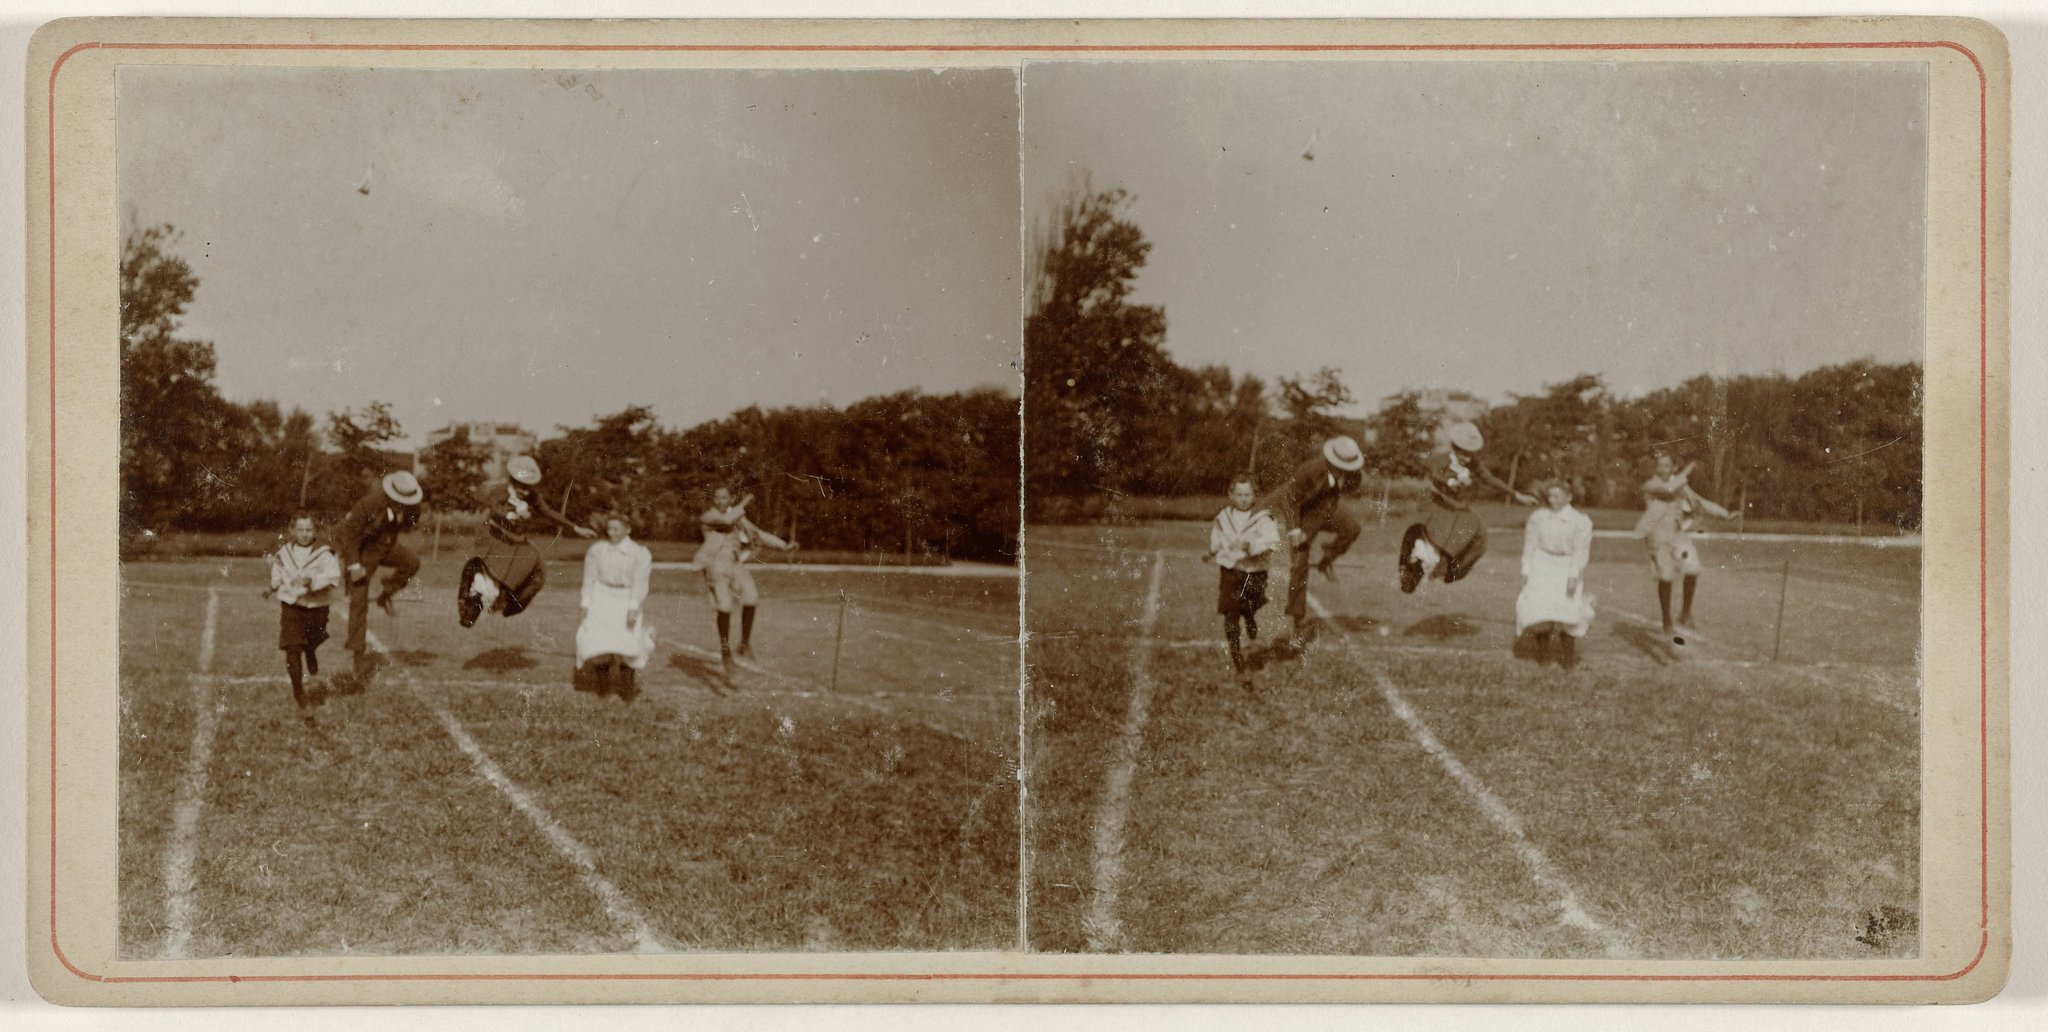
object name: stereograph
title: Stereoscopic Photographs of the Photographer’s Children Running and Jumping, Domburg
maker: geldolph adriaan kessler (dolph)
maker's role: fotograaf, industrieel, voetballer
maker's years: 1884-1945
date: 1899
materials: cardboard, paper, photographic support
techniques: collodion silver print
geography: domburg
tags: domburg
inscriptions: title: ‘Domburg 1899’